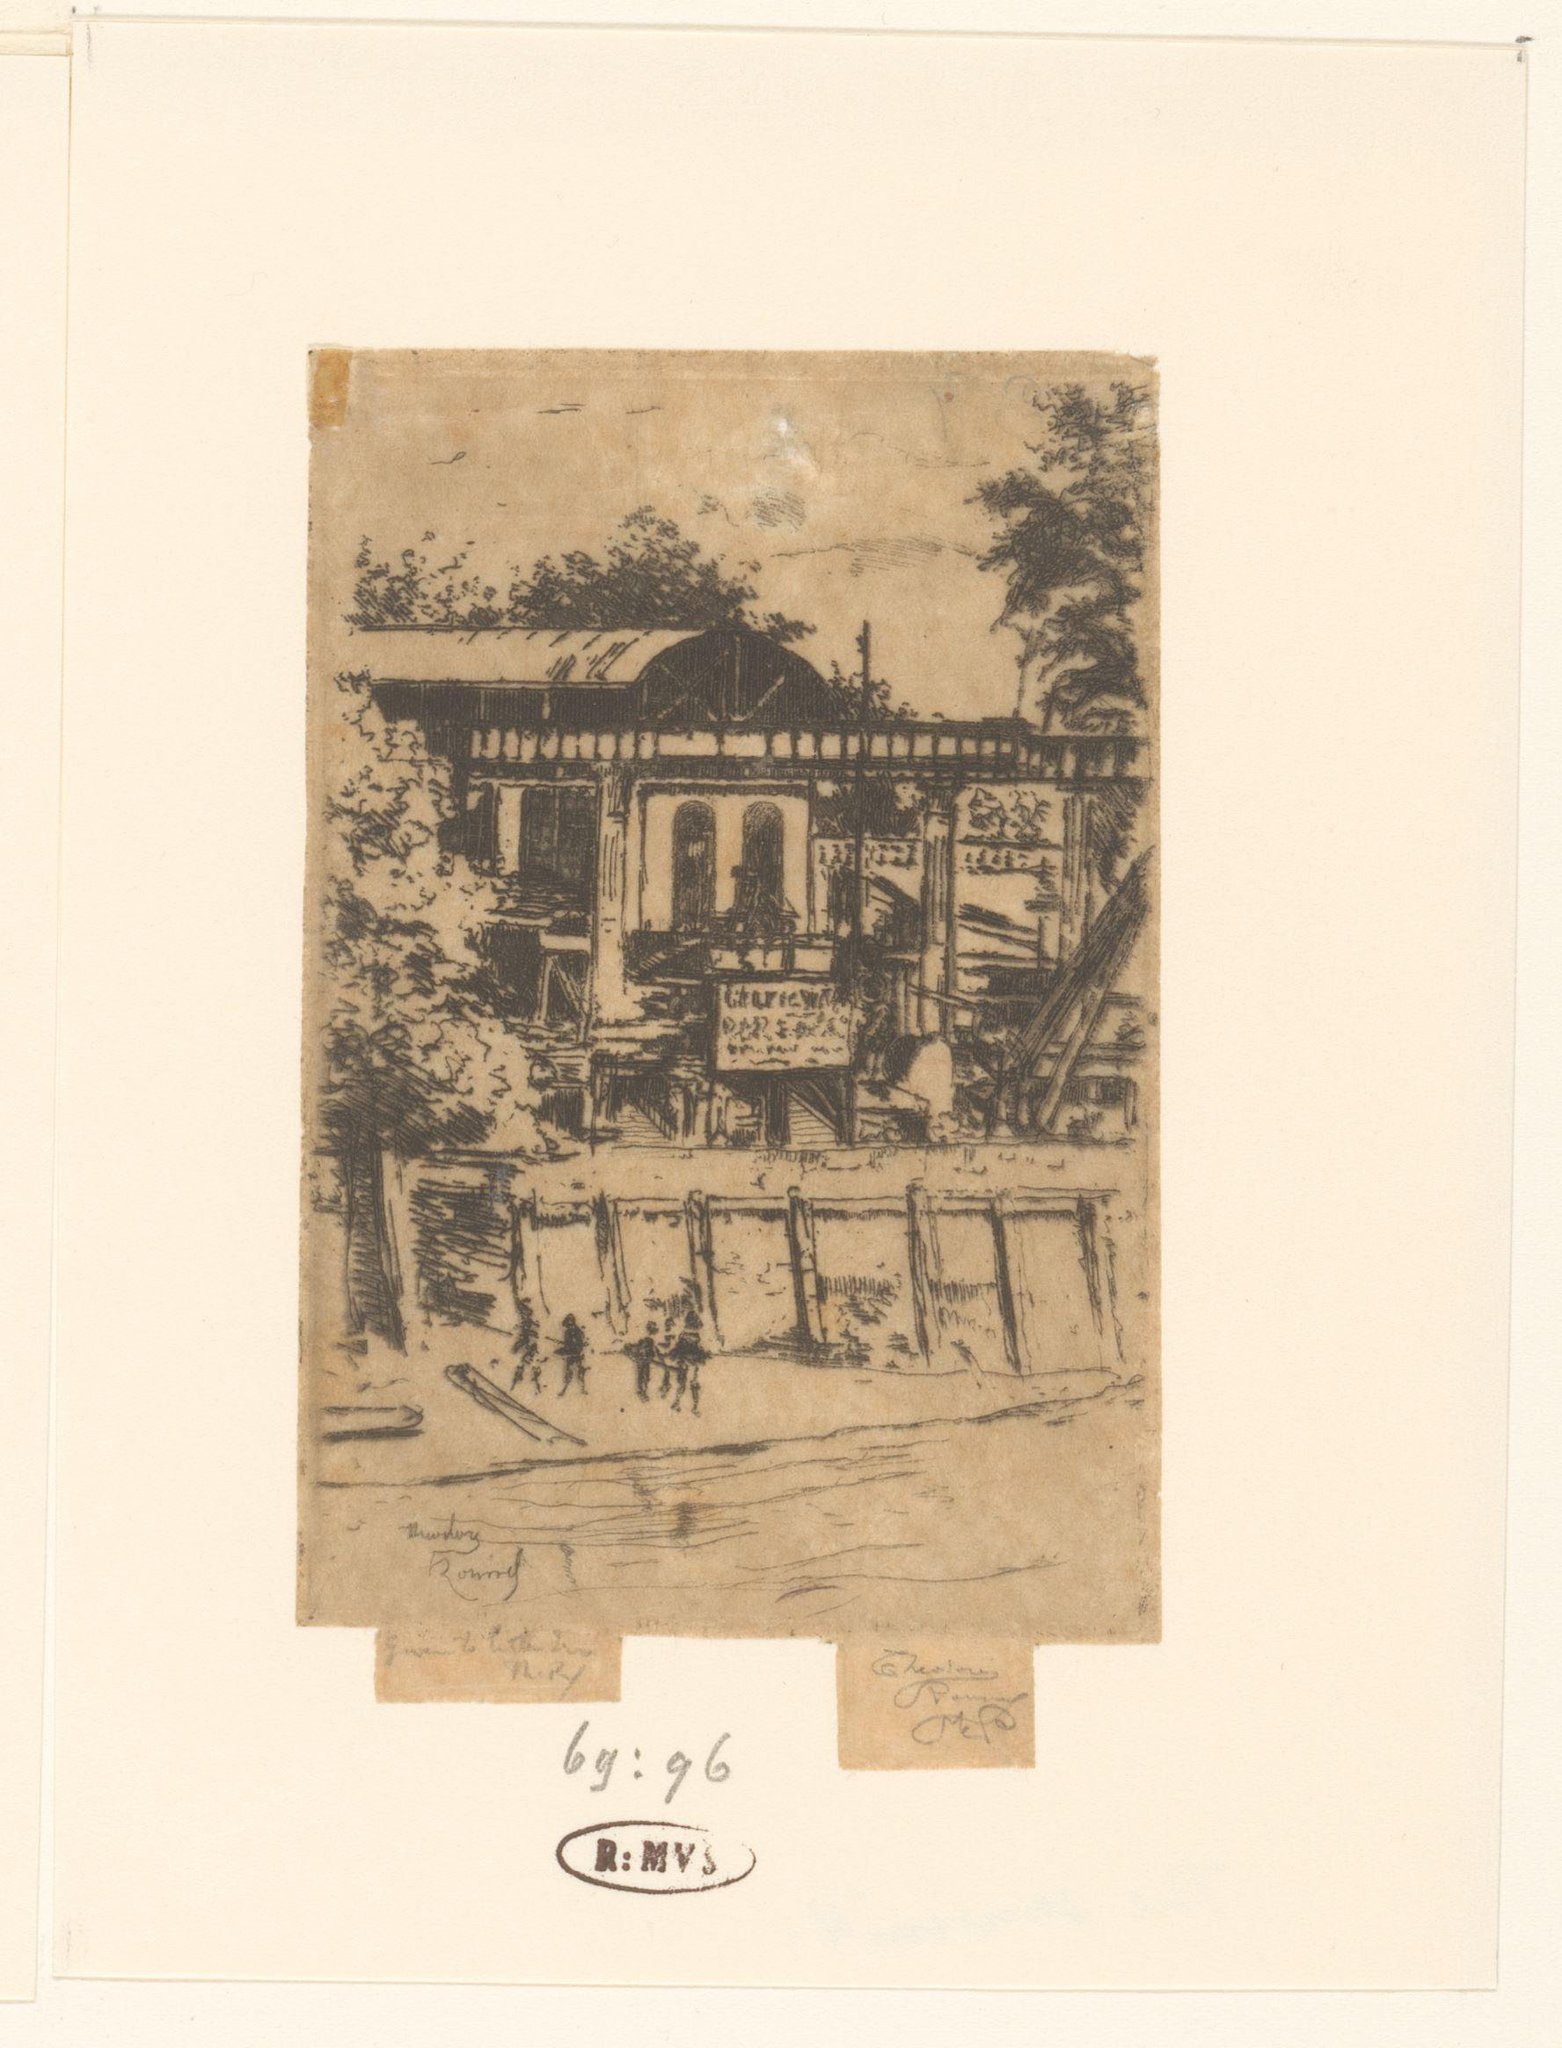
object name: print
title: The Saw Mill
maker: théodore roussel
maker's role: print maker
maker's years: 1847-1926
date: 1888-1889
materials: paper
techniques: etching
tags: saw-mill (works), timber yard, lumber stack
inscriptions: collector's mark: Lugt 2228